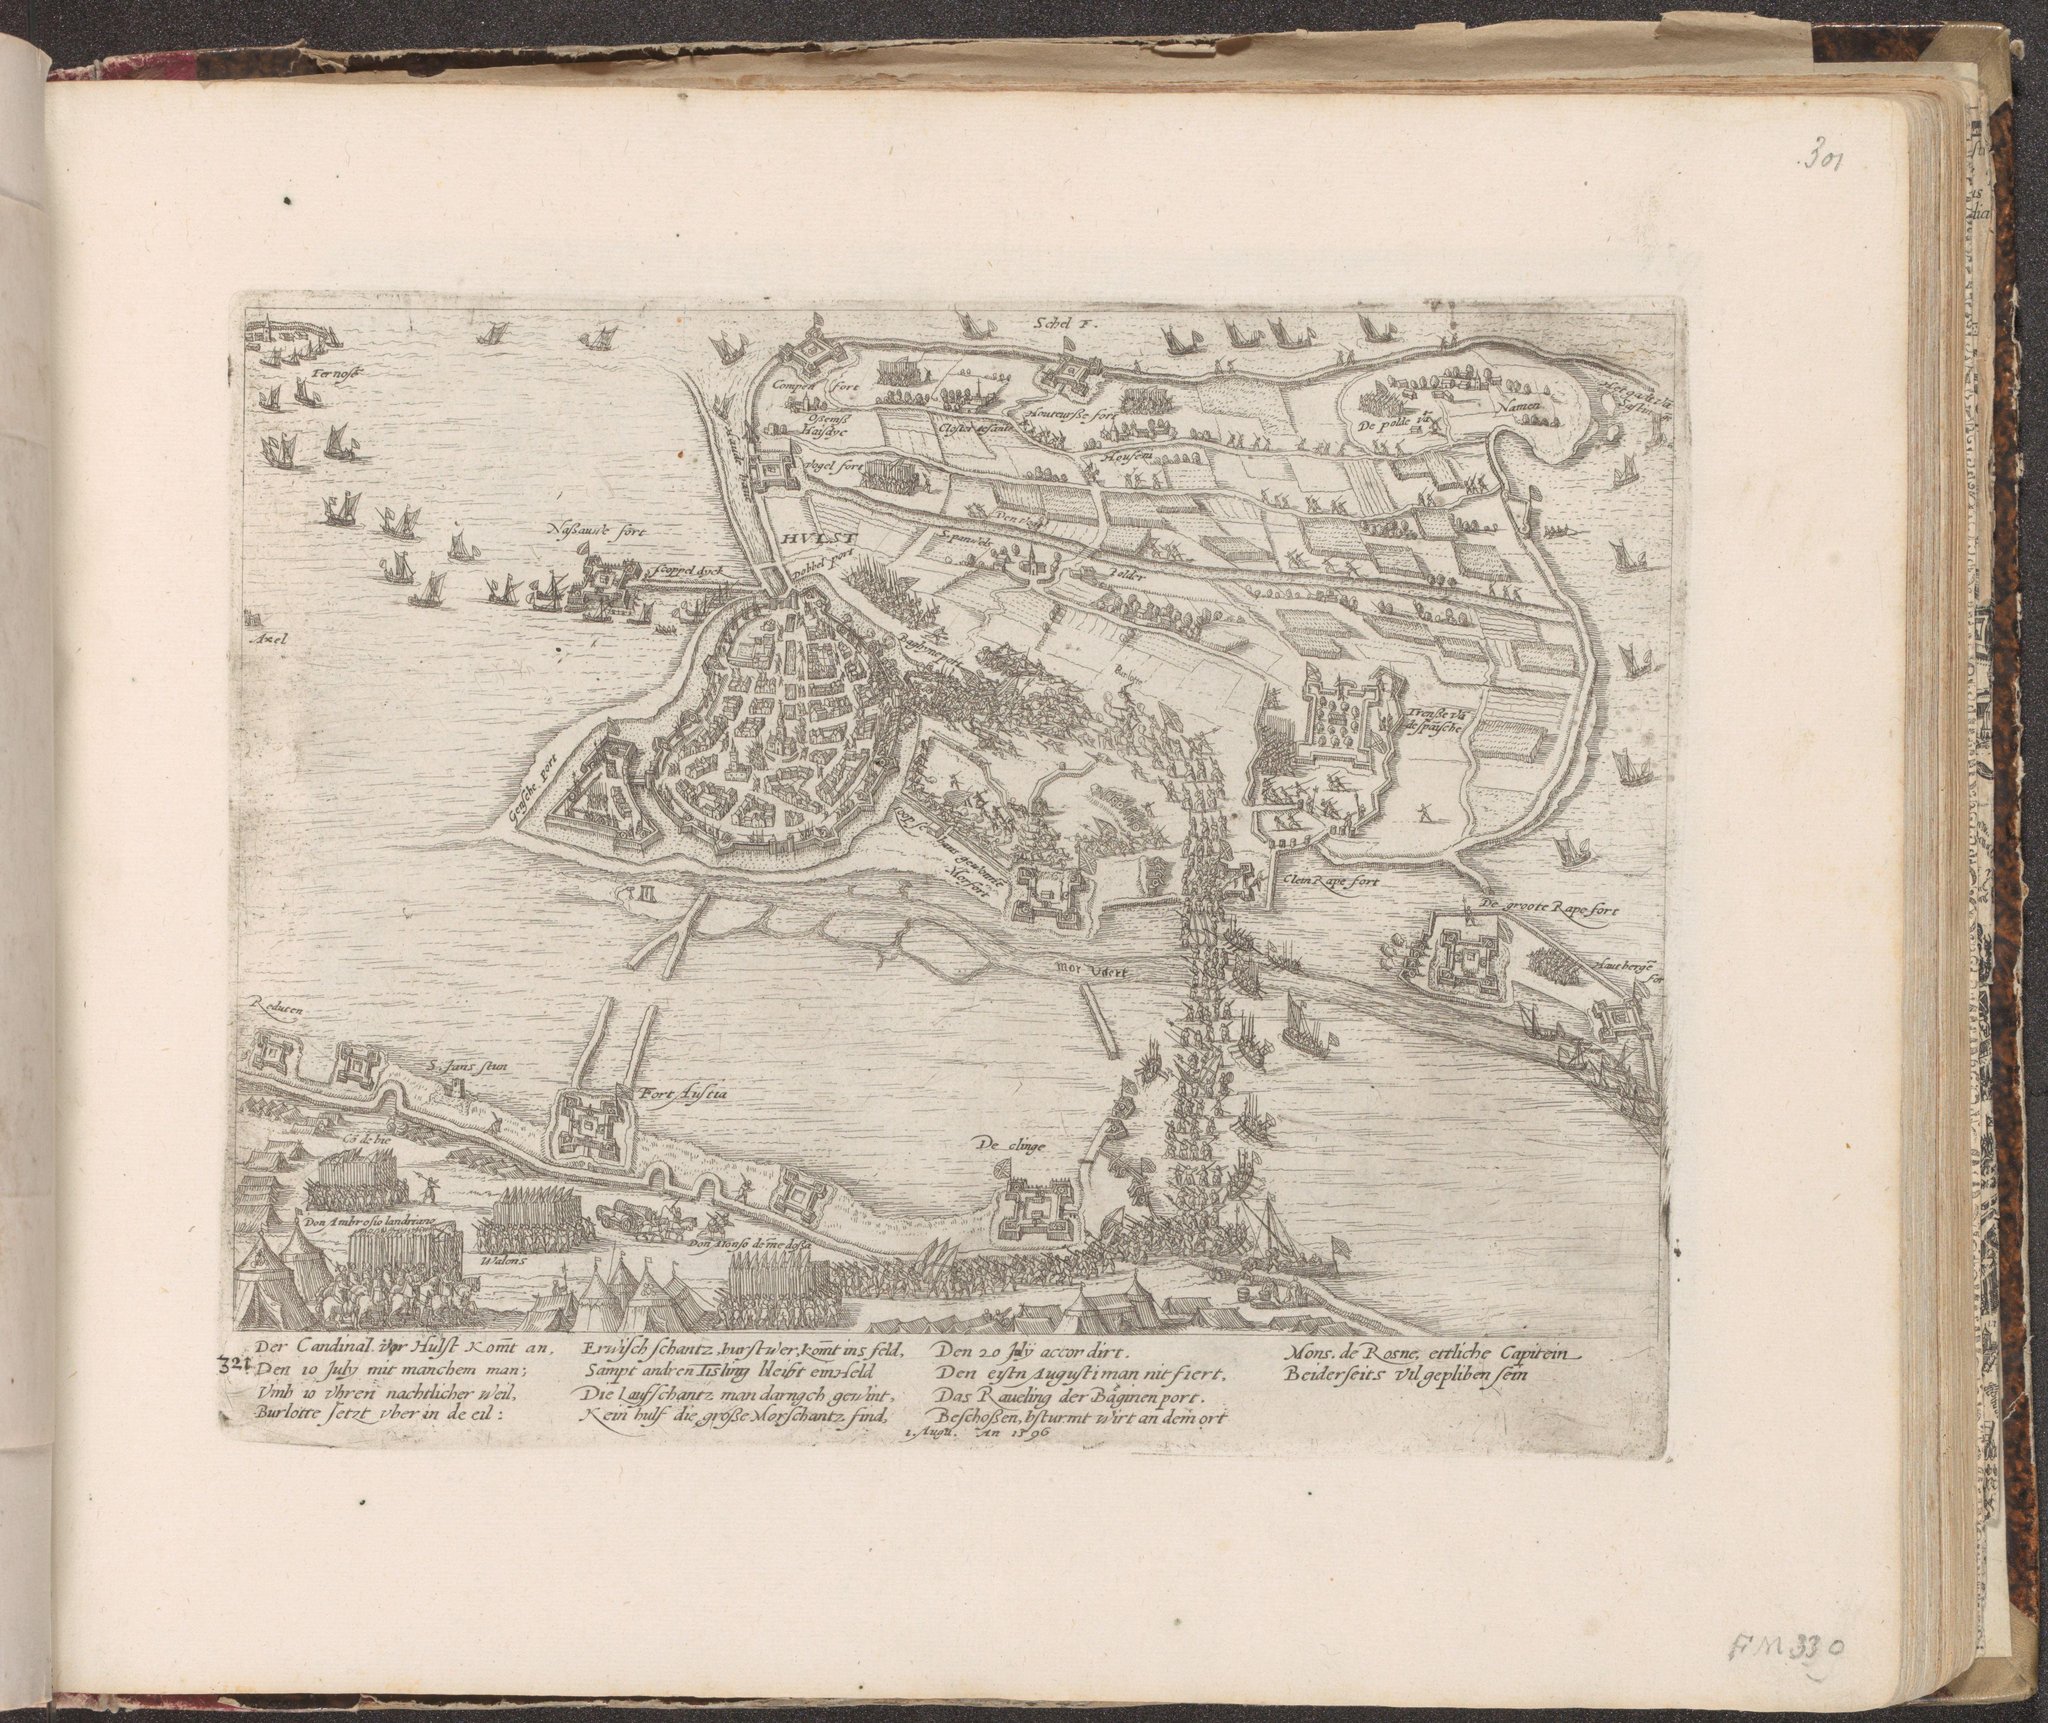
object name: album leaf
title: Beleg van Hulst door de Spanjaarden, 1596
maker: frans hogenberg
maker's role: print maker, publisher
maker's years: 1538-1590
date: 1596-1598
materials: paper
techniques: etching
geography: cologne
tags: capture of city (after the siege)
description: Beleg van Hulst door de Spanjaarden, 8 juli - 2 augustus 1596. Overzicht van Hulst en omgeving met de opmars van de Spaanse troepen in de richting van Hulst. In de omgeving een groot aantal schansen. Met onderschrift van 14 regels in het Duits. Linksonder genummerd: 321. De prent maakt deel uit van een album.